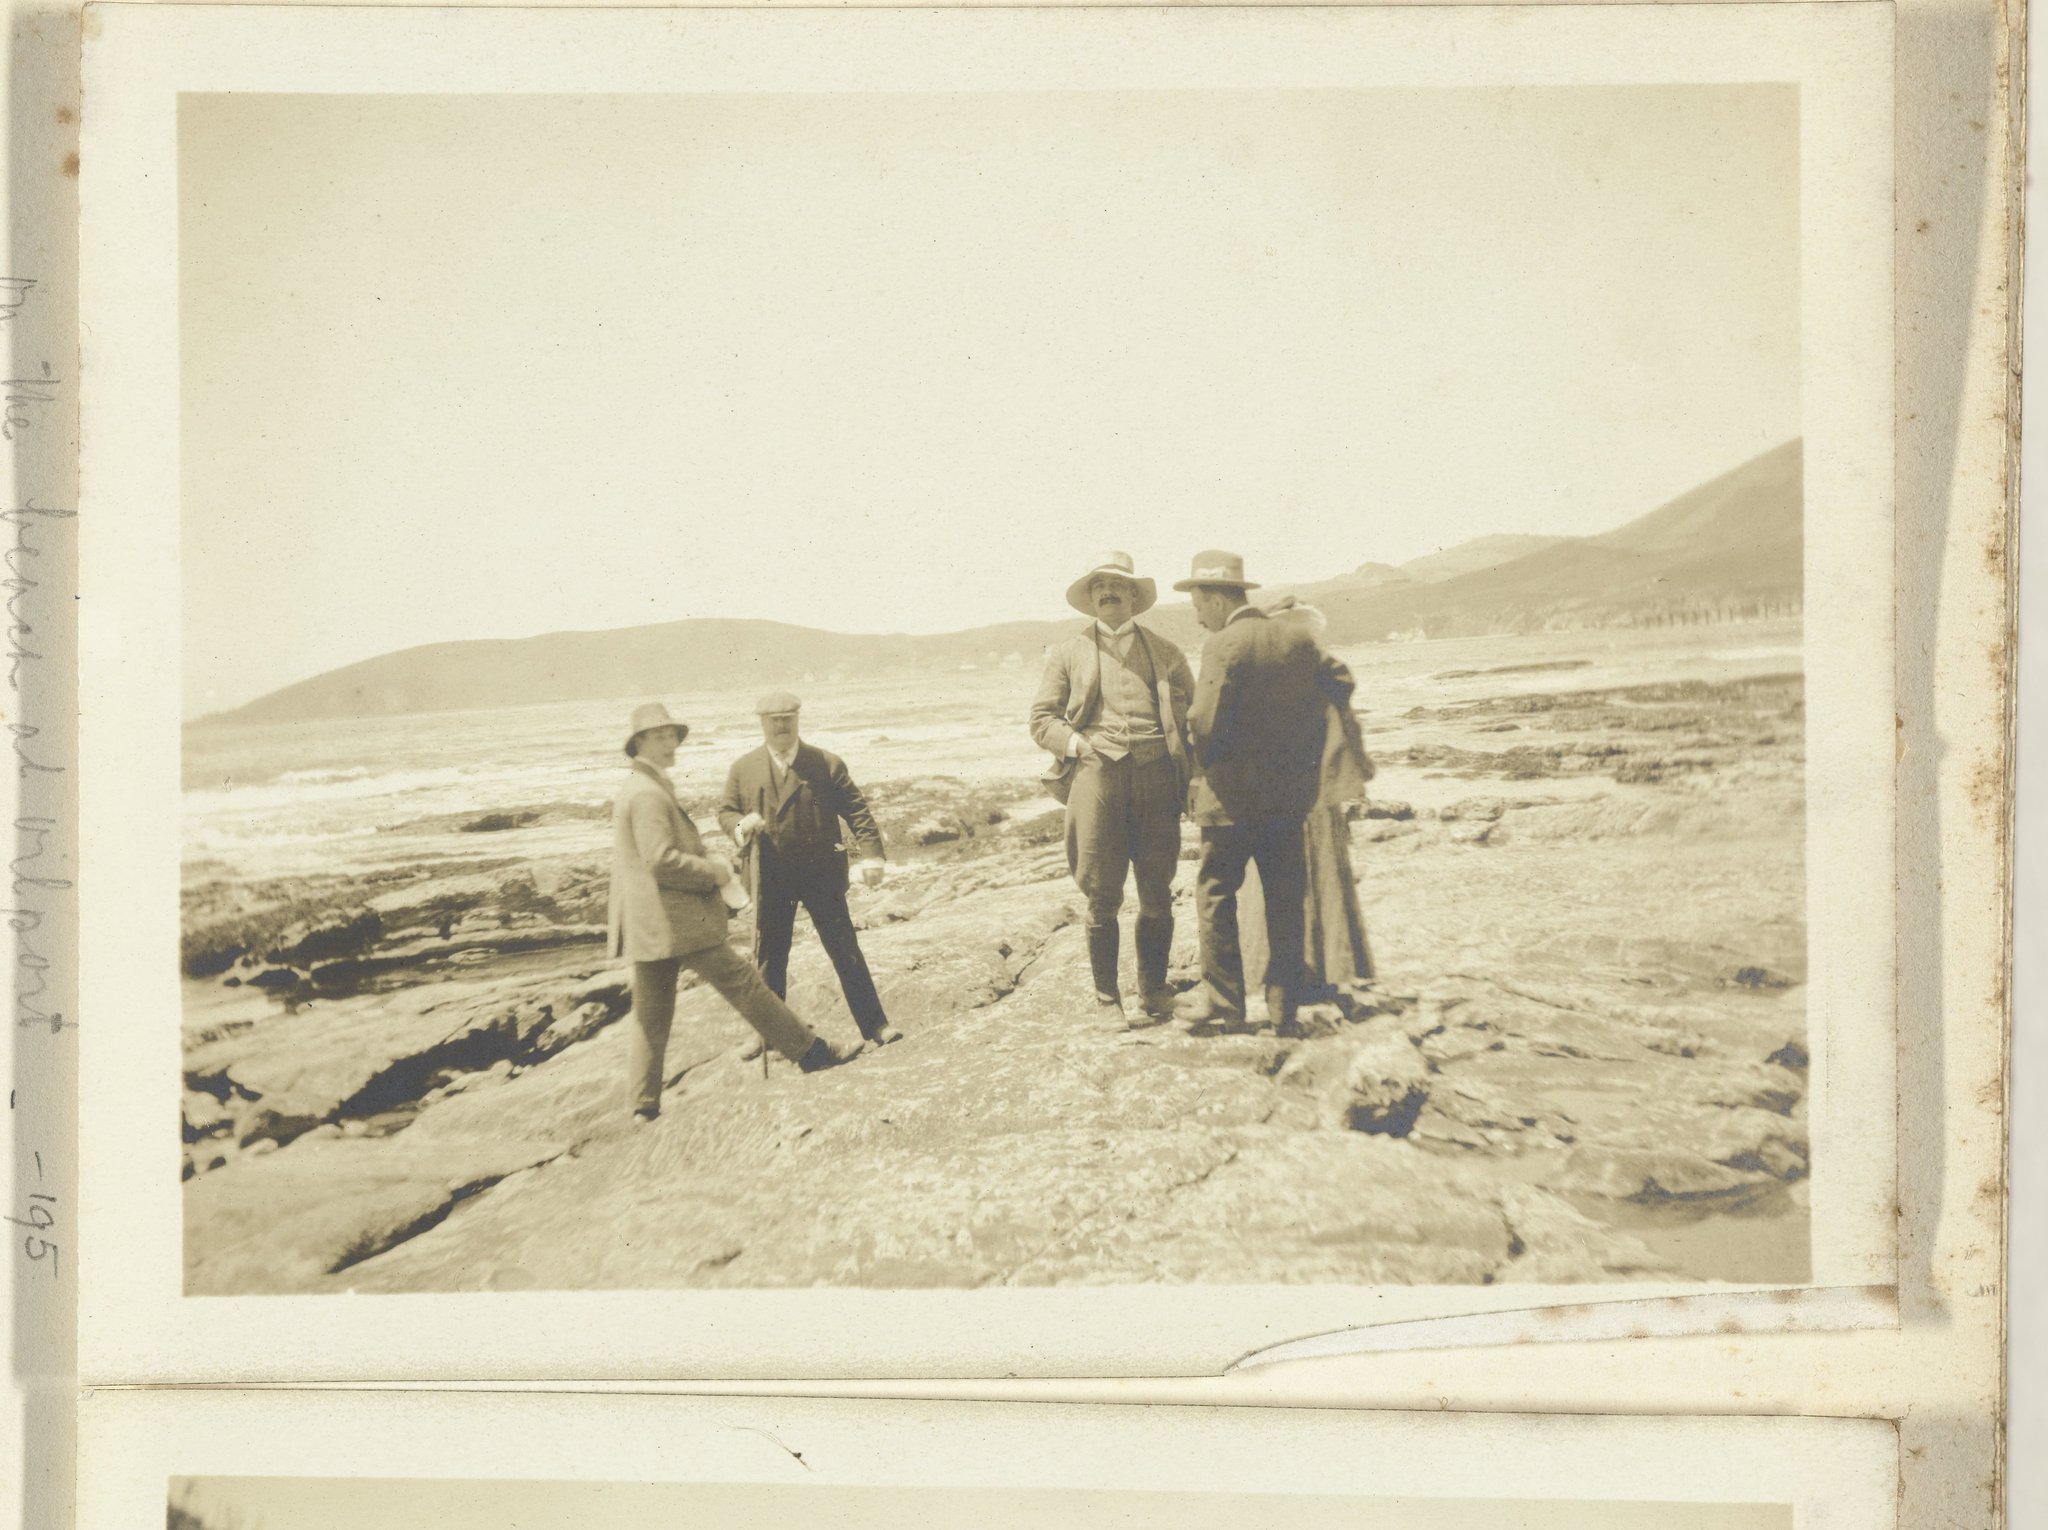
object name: photograph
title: On the beach at oilport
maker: geldolph adriaan kessler (dolph)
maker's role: fotograaf, industrieel, voetballer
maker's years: 1884-1945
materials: cardboard, photographic support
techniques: gelatin silver print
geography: california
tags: californië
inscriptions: title: ‘On the beach at Oilport’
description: Het reisgezelschap op het strand bij de oliehaven. Onderdeel van het fotoalbum van Dolph Kessler met opnamen die hij maakte tijdens zijn verblijf in Engeland en op een wereldreis die hij als secretaris van Henri Deterding (directeur Koninklijke Olie) ondernam naar Nederlands-Indië, Japan, China en de Verenigde Staten, tussen 1906 en 1908.